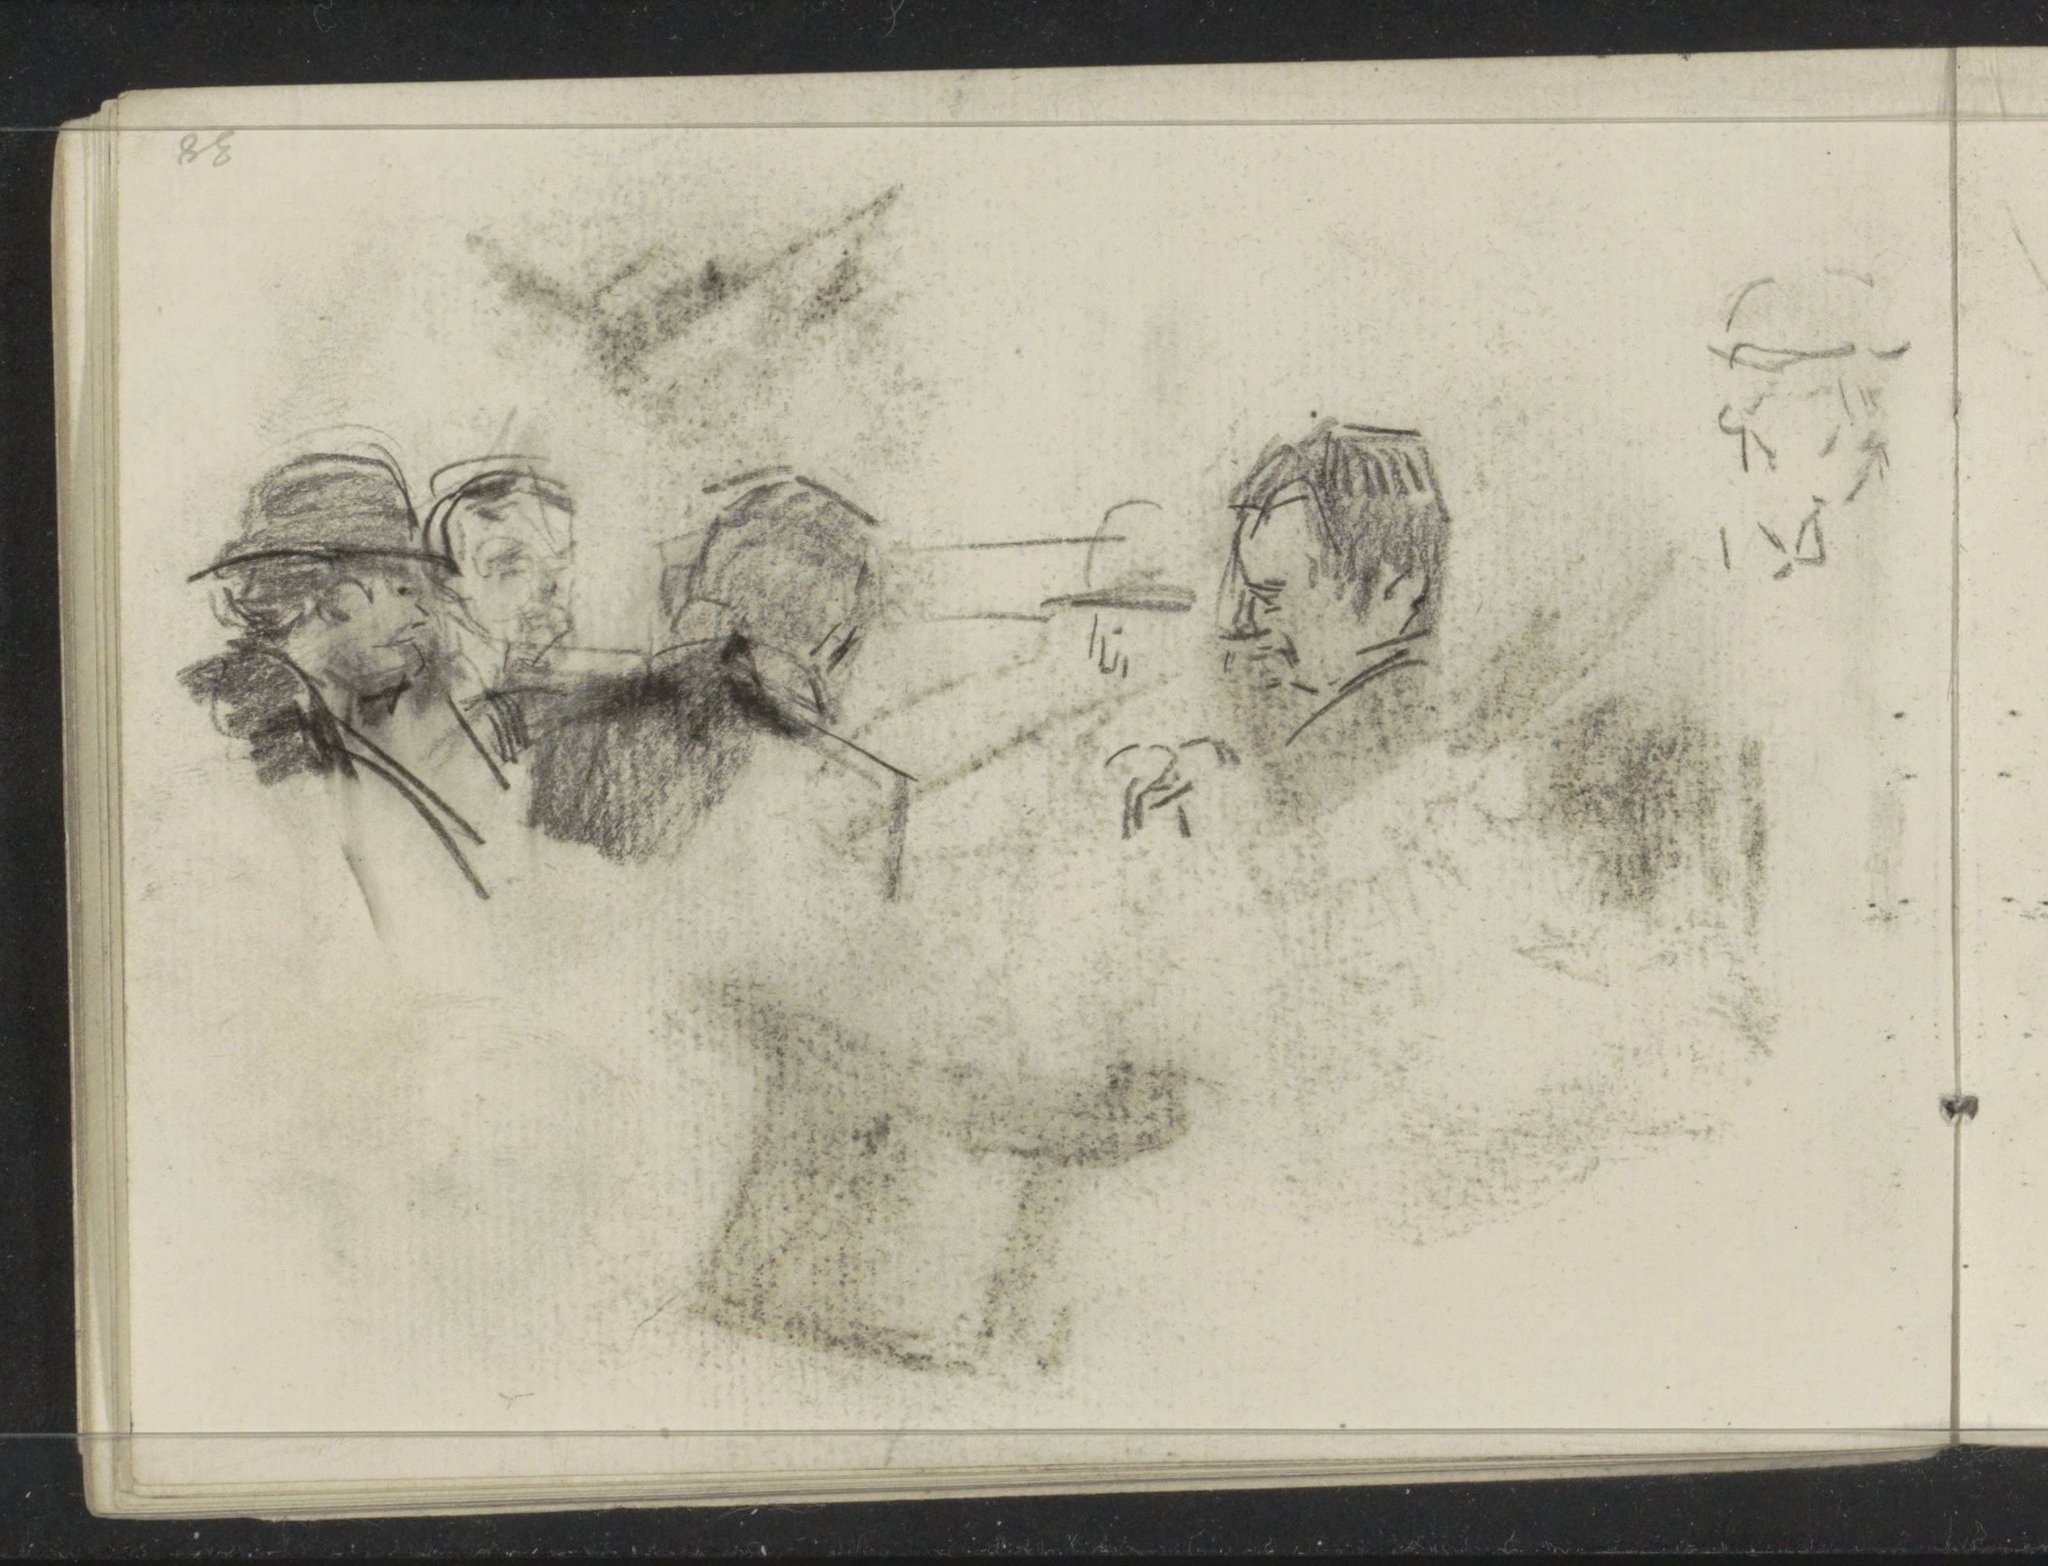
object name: sketchbook leaf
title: Mannenhoofden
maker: isaac israels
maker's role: draughtsman, painter, print maker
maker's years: 1865-1934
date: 1886-1934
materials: chalk, paper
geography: amsterdam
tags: head (human), head-gear: hat (+ men's clothes)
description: Mogelijk van mannen die rond een tafel zitten. Blad 21 verso uit schetsboek LXIV met 29 bladen.